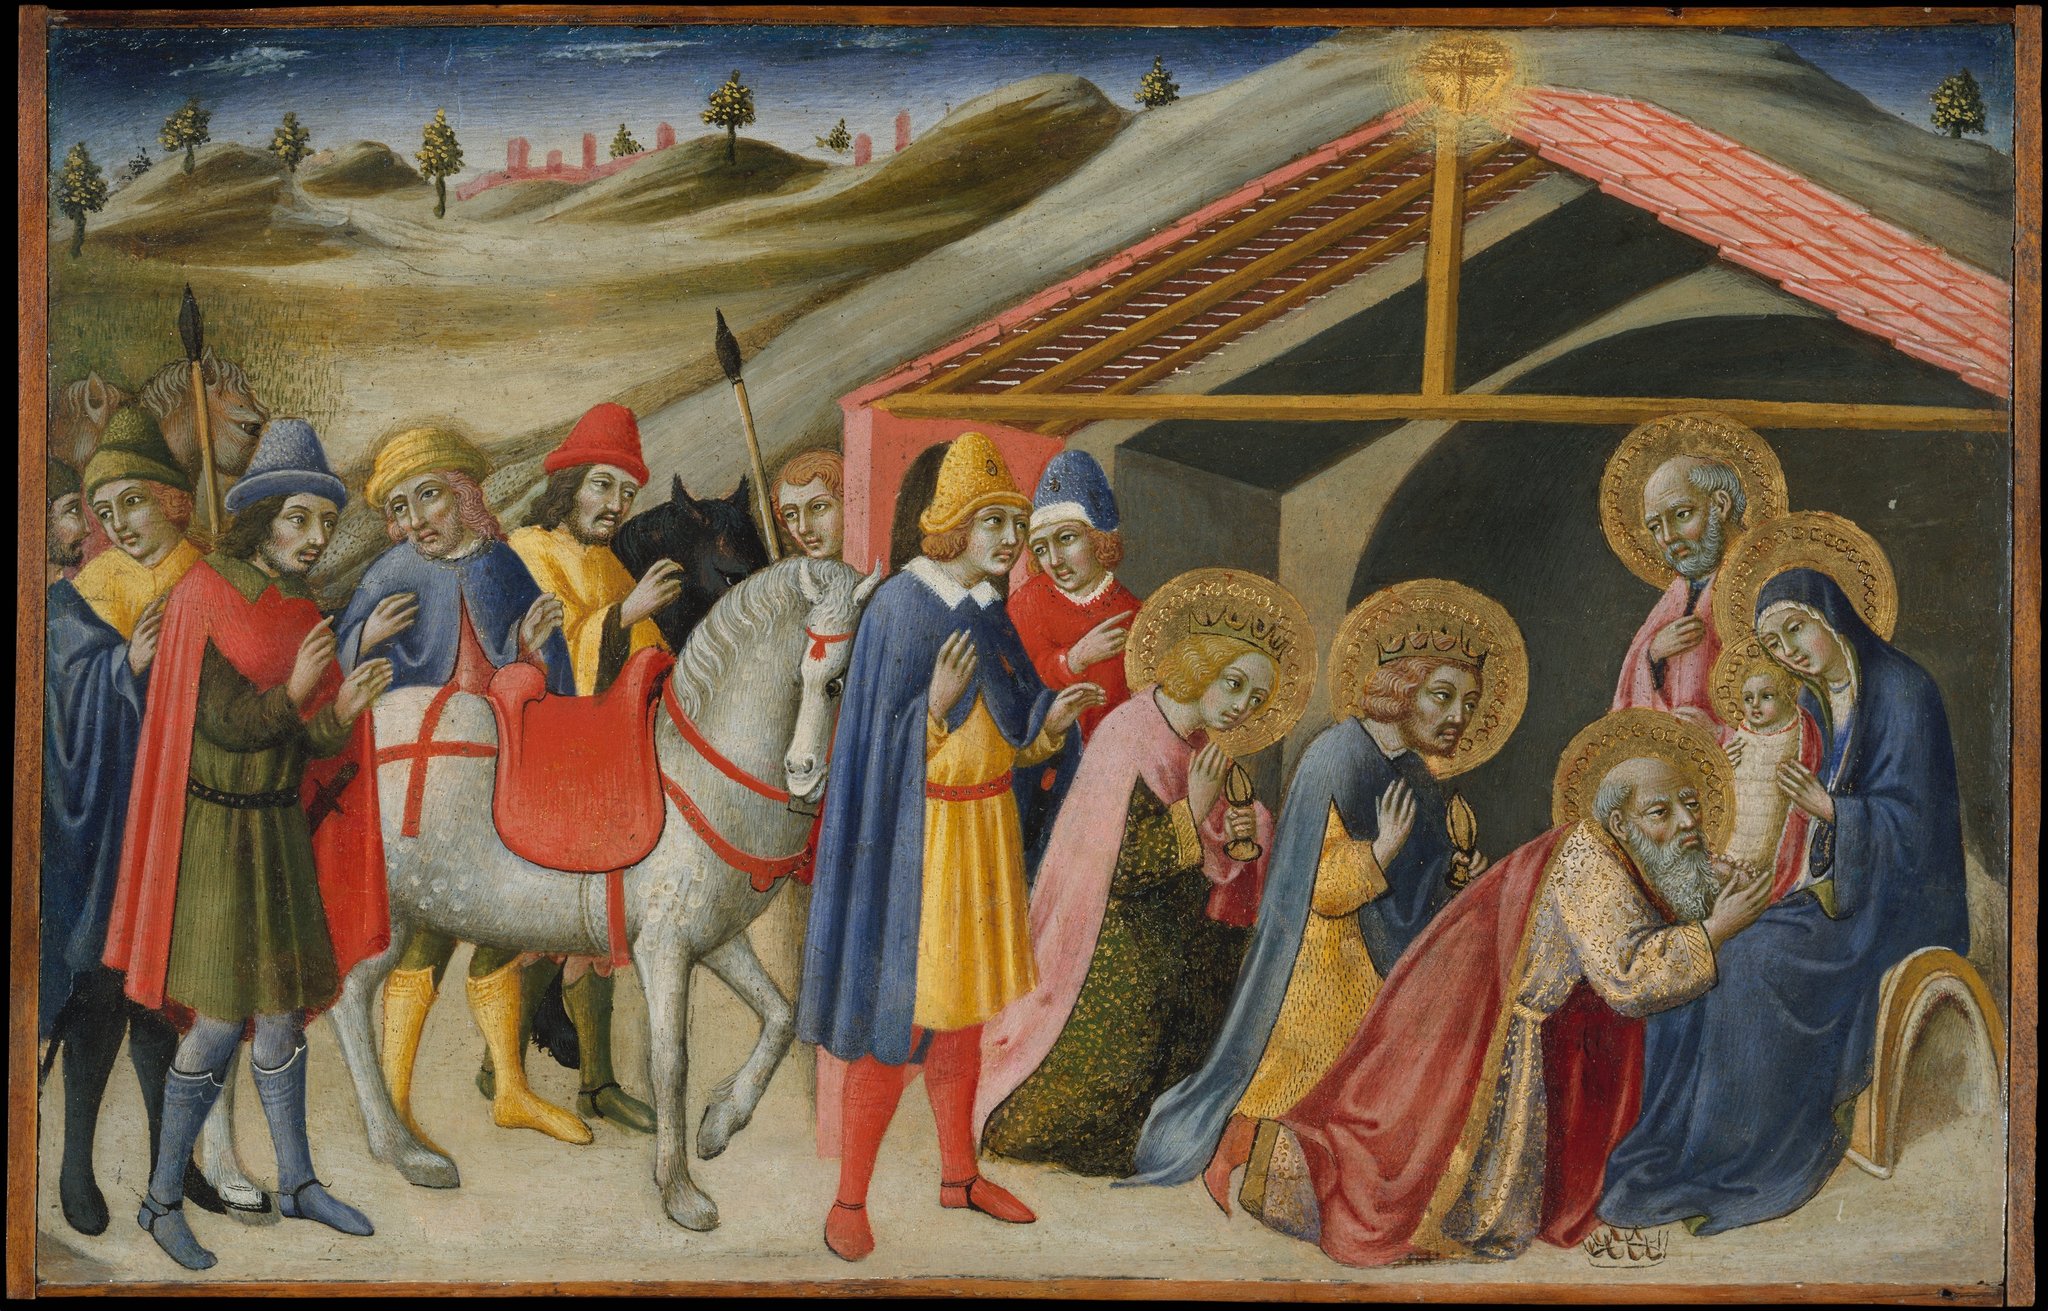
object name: painting, predella panel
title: The Adoration of the Magi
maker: sano di pietro (ansano di pietro di mencio)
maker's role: artist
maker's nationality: italian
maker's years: 1405-1481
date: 1470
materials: gold, paint, wood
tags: horses,adoration of the magi